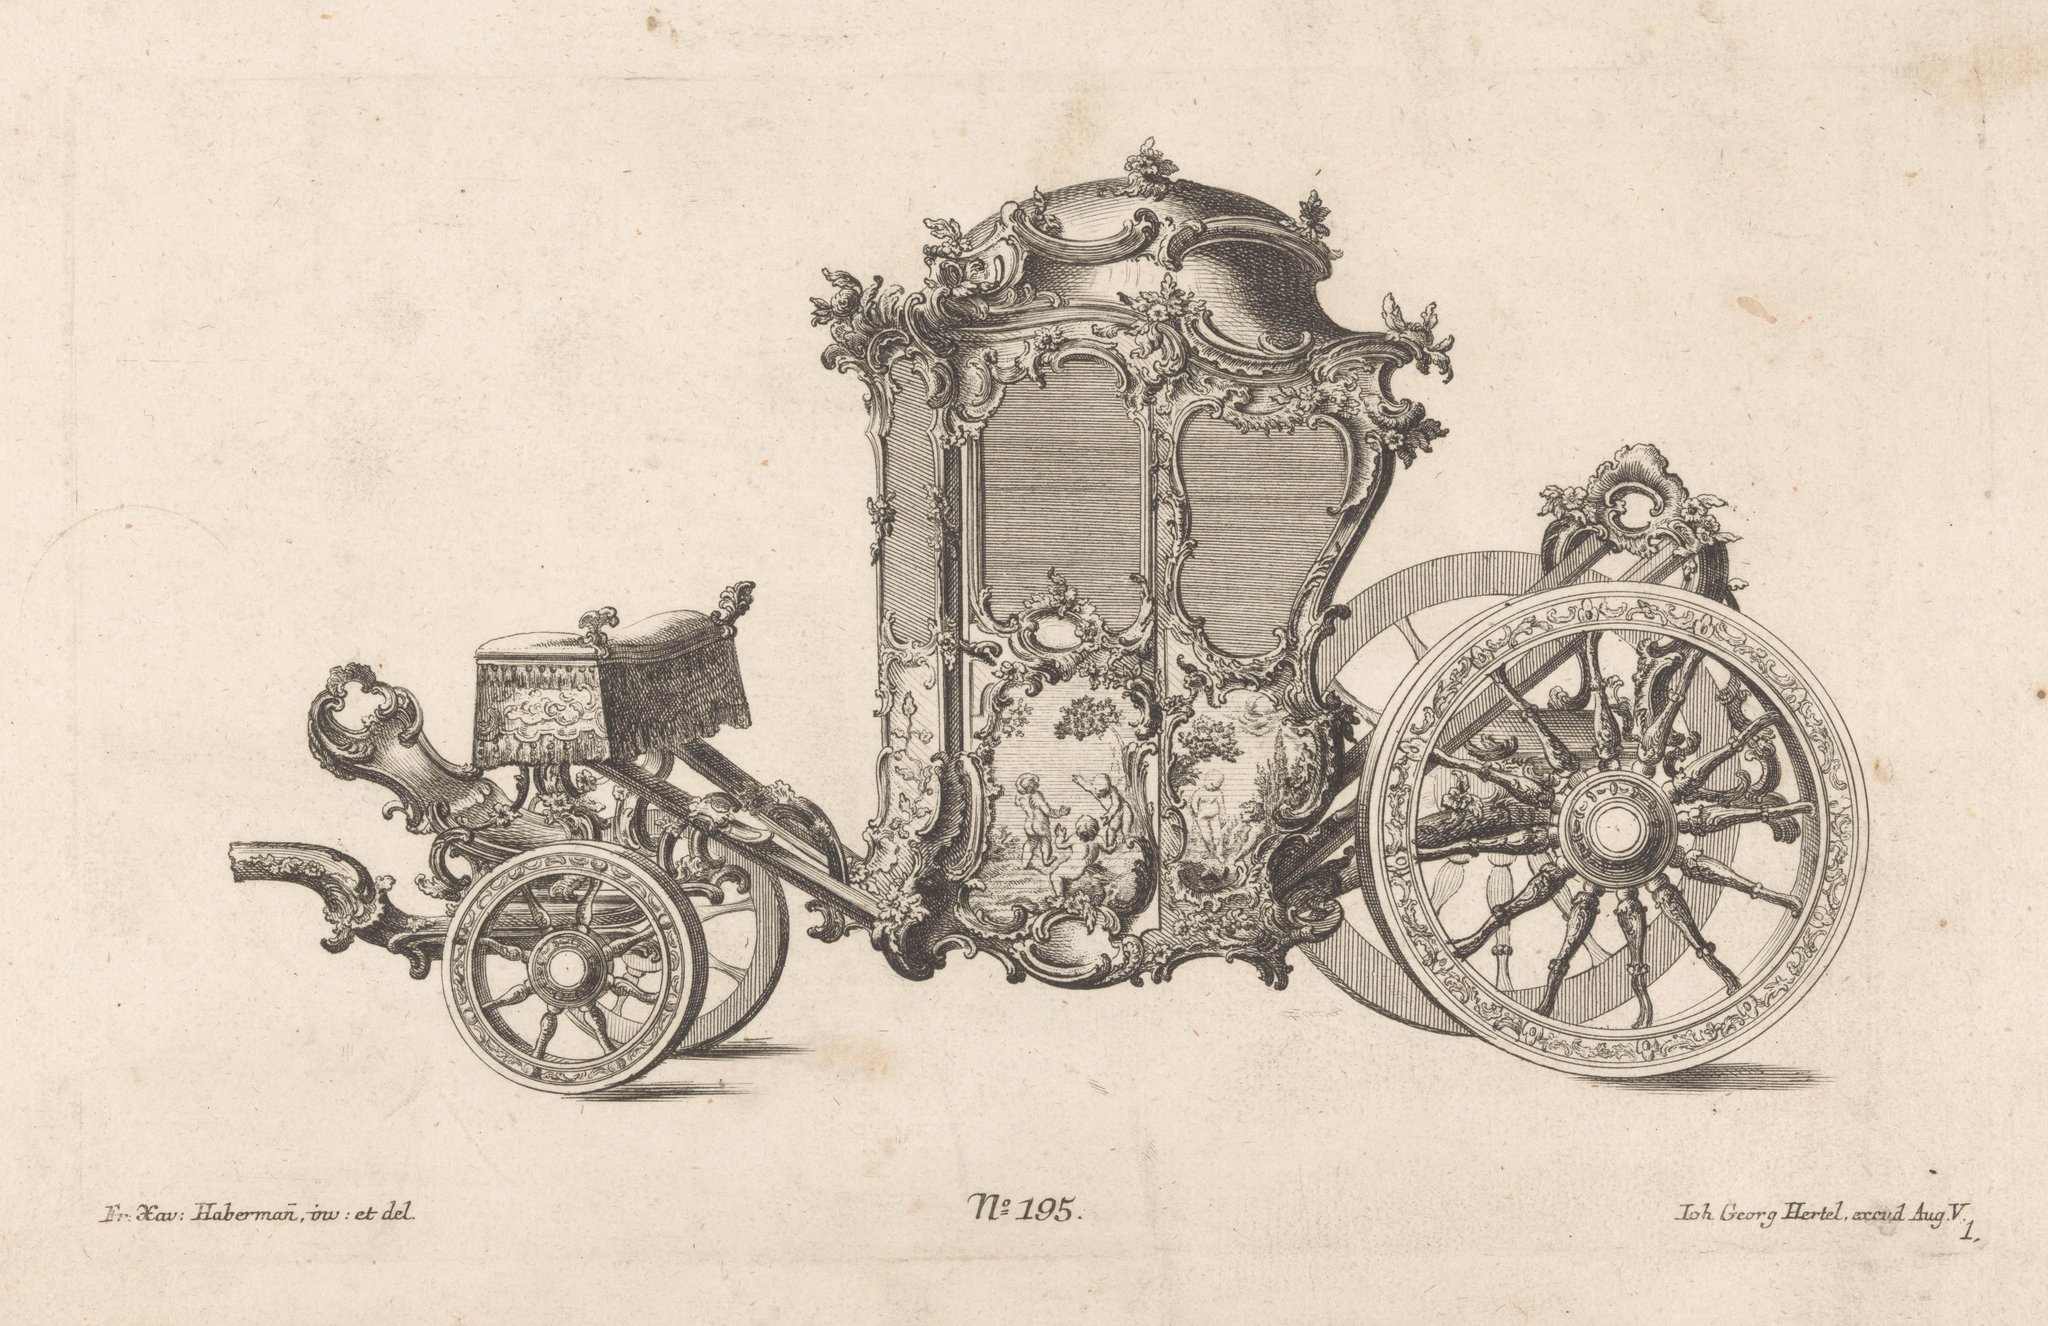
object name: print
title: Rijtuigen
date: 1731-1775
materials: paper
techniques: engraving, etching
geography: augsburg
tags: four-wheeled, animal-drawn vehicle, e.g.: cab, carriage, coach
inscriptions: collector's mark: Lugt 2760, collector's mark: Lugt 2228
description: Dichte koets met rocaille ornamenten, bloemmotieven en beschilderingen met putti in landschap. Uitgeversnummer 195.